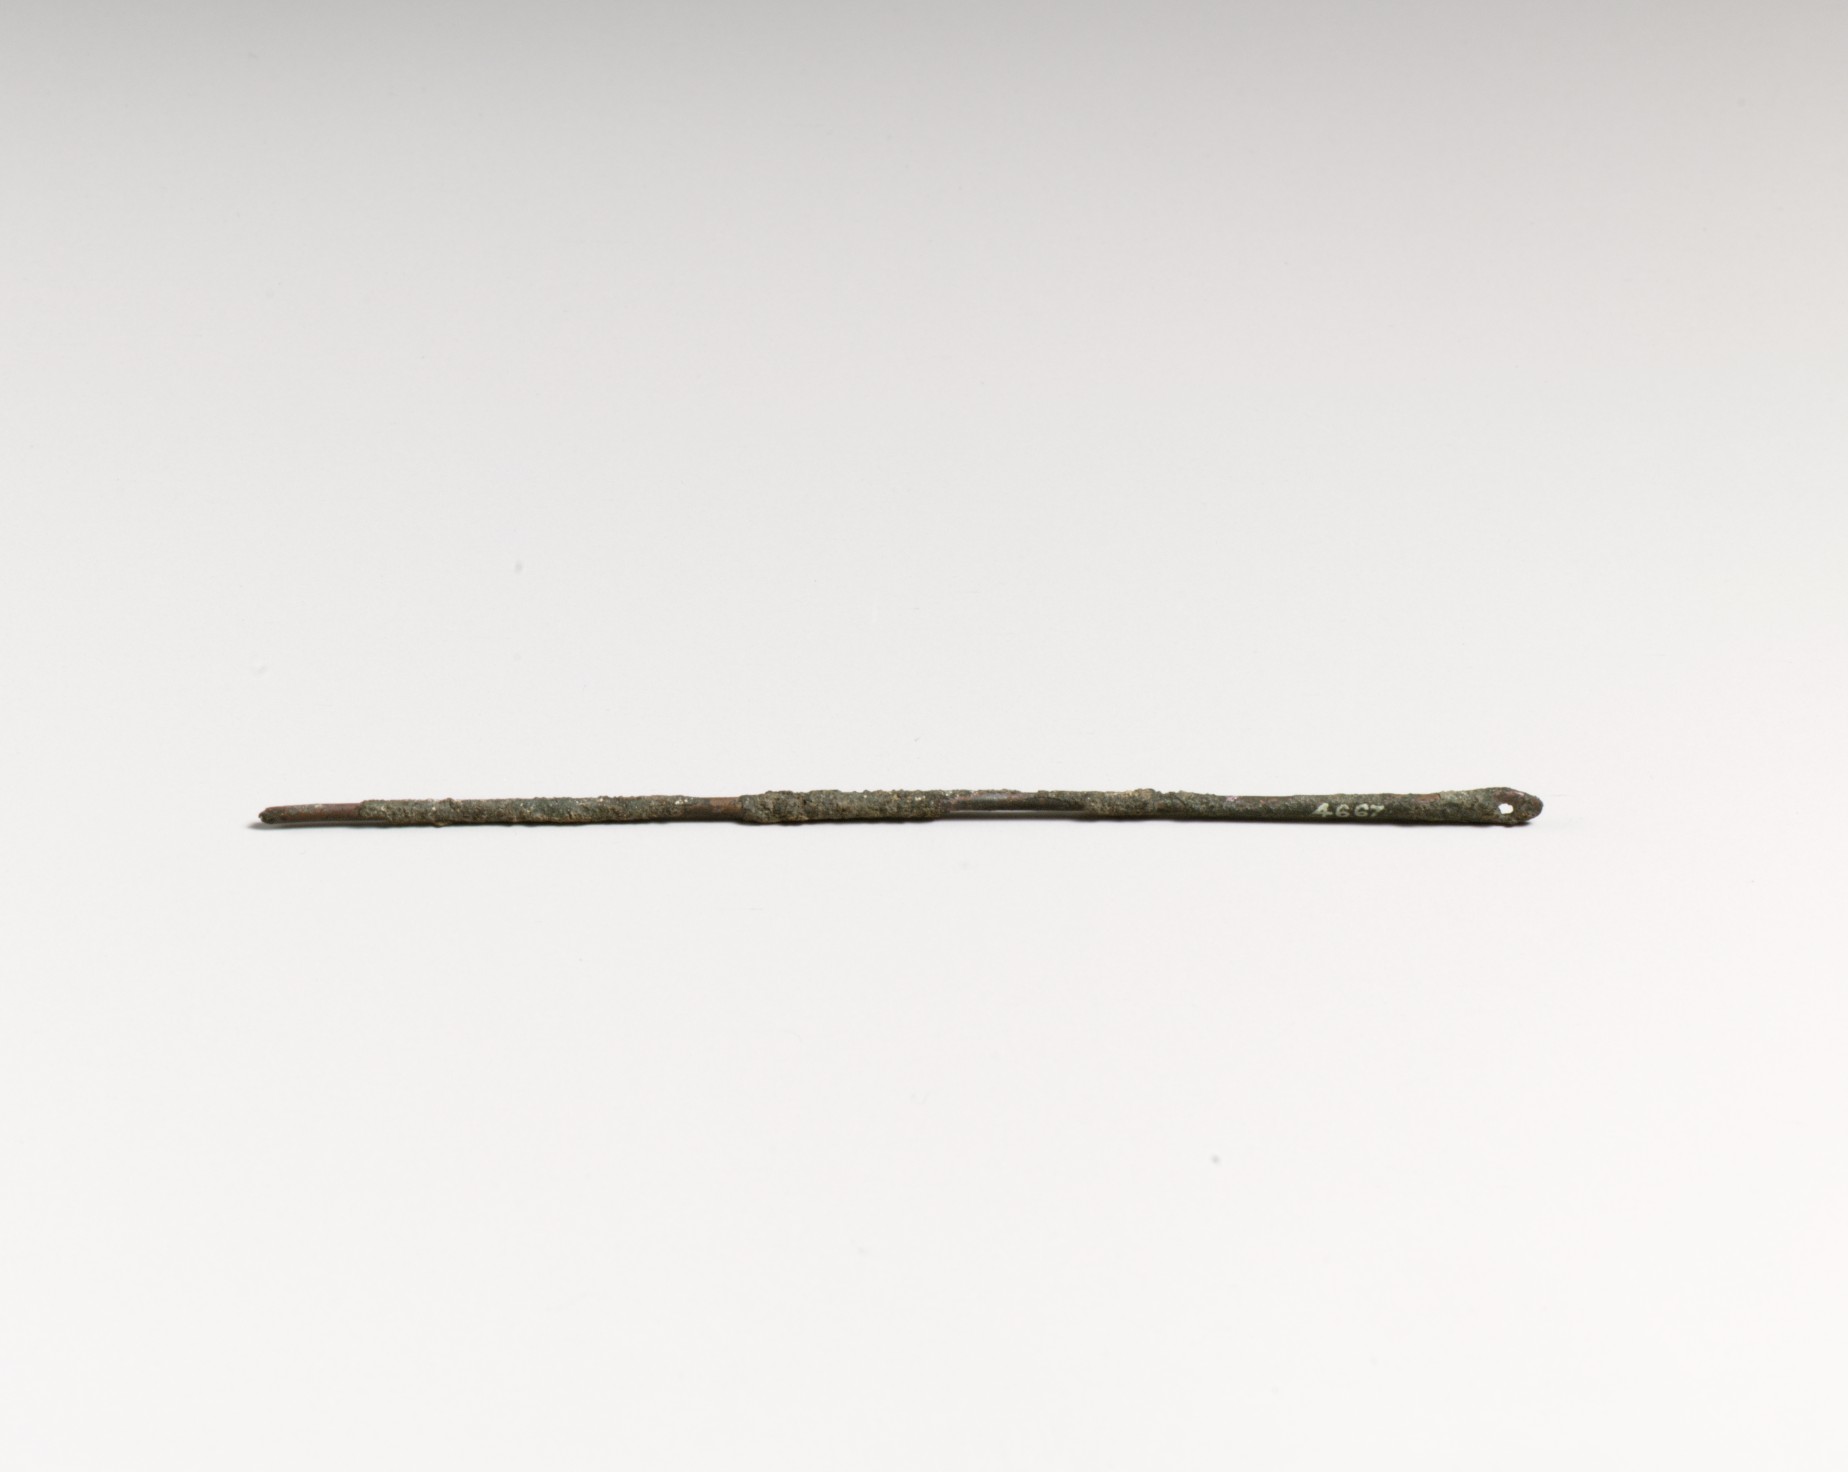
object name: needle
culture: cypriot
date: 3900 BCE-100 CE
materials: bronze